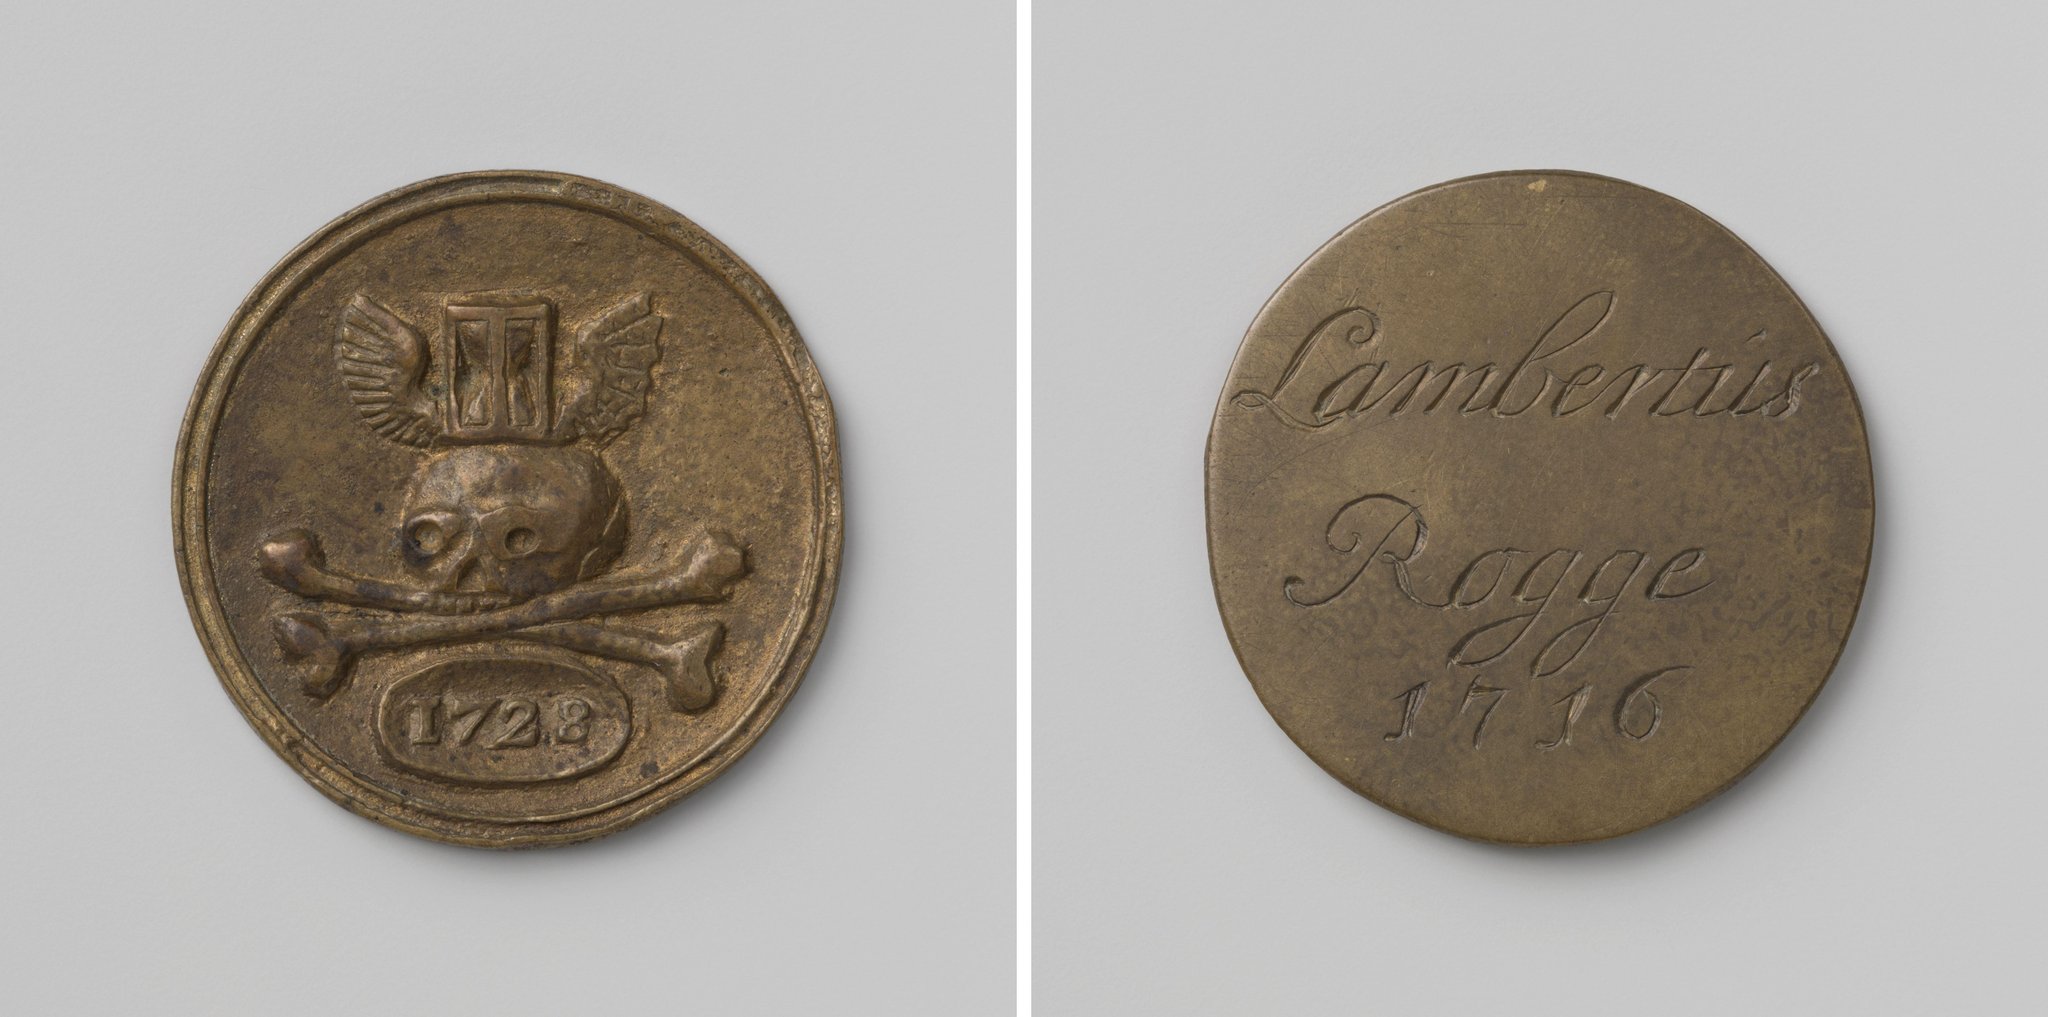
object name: funeral token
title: Kuipersgilde van Amsterdam, begrafenispenning van Lambertus Rogge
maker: Anonymous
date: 1728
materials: brass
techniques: casting, engraving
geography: amsterdam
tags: amsterdam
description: Messing penning. Voorzijde: gevleugelde zandloper boven doodshoofd, twee gekruiste beenderen en jaartal in compartiment. Keerzijde: opschrift boven jaartal